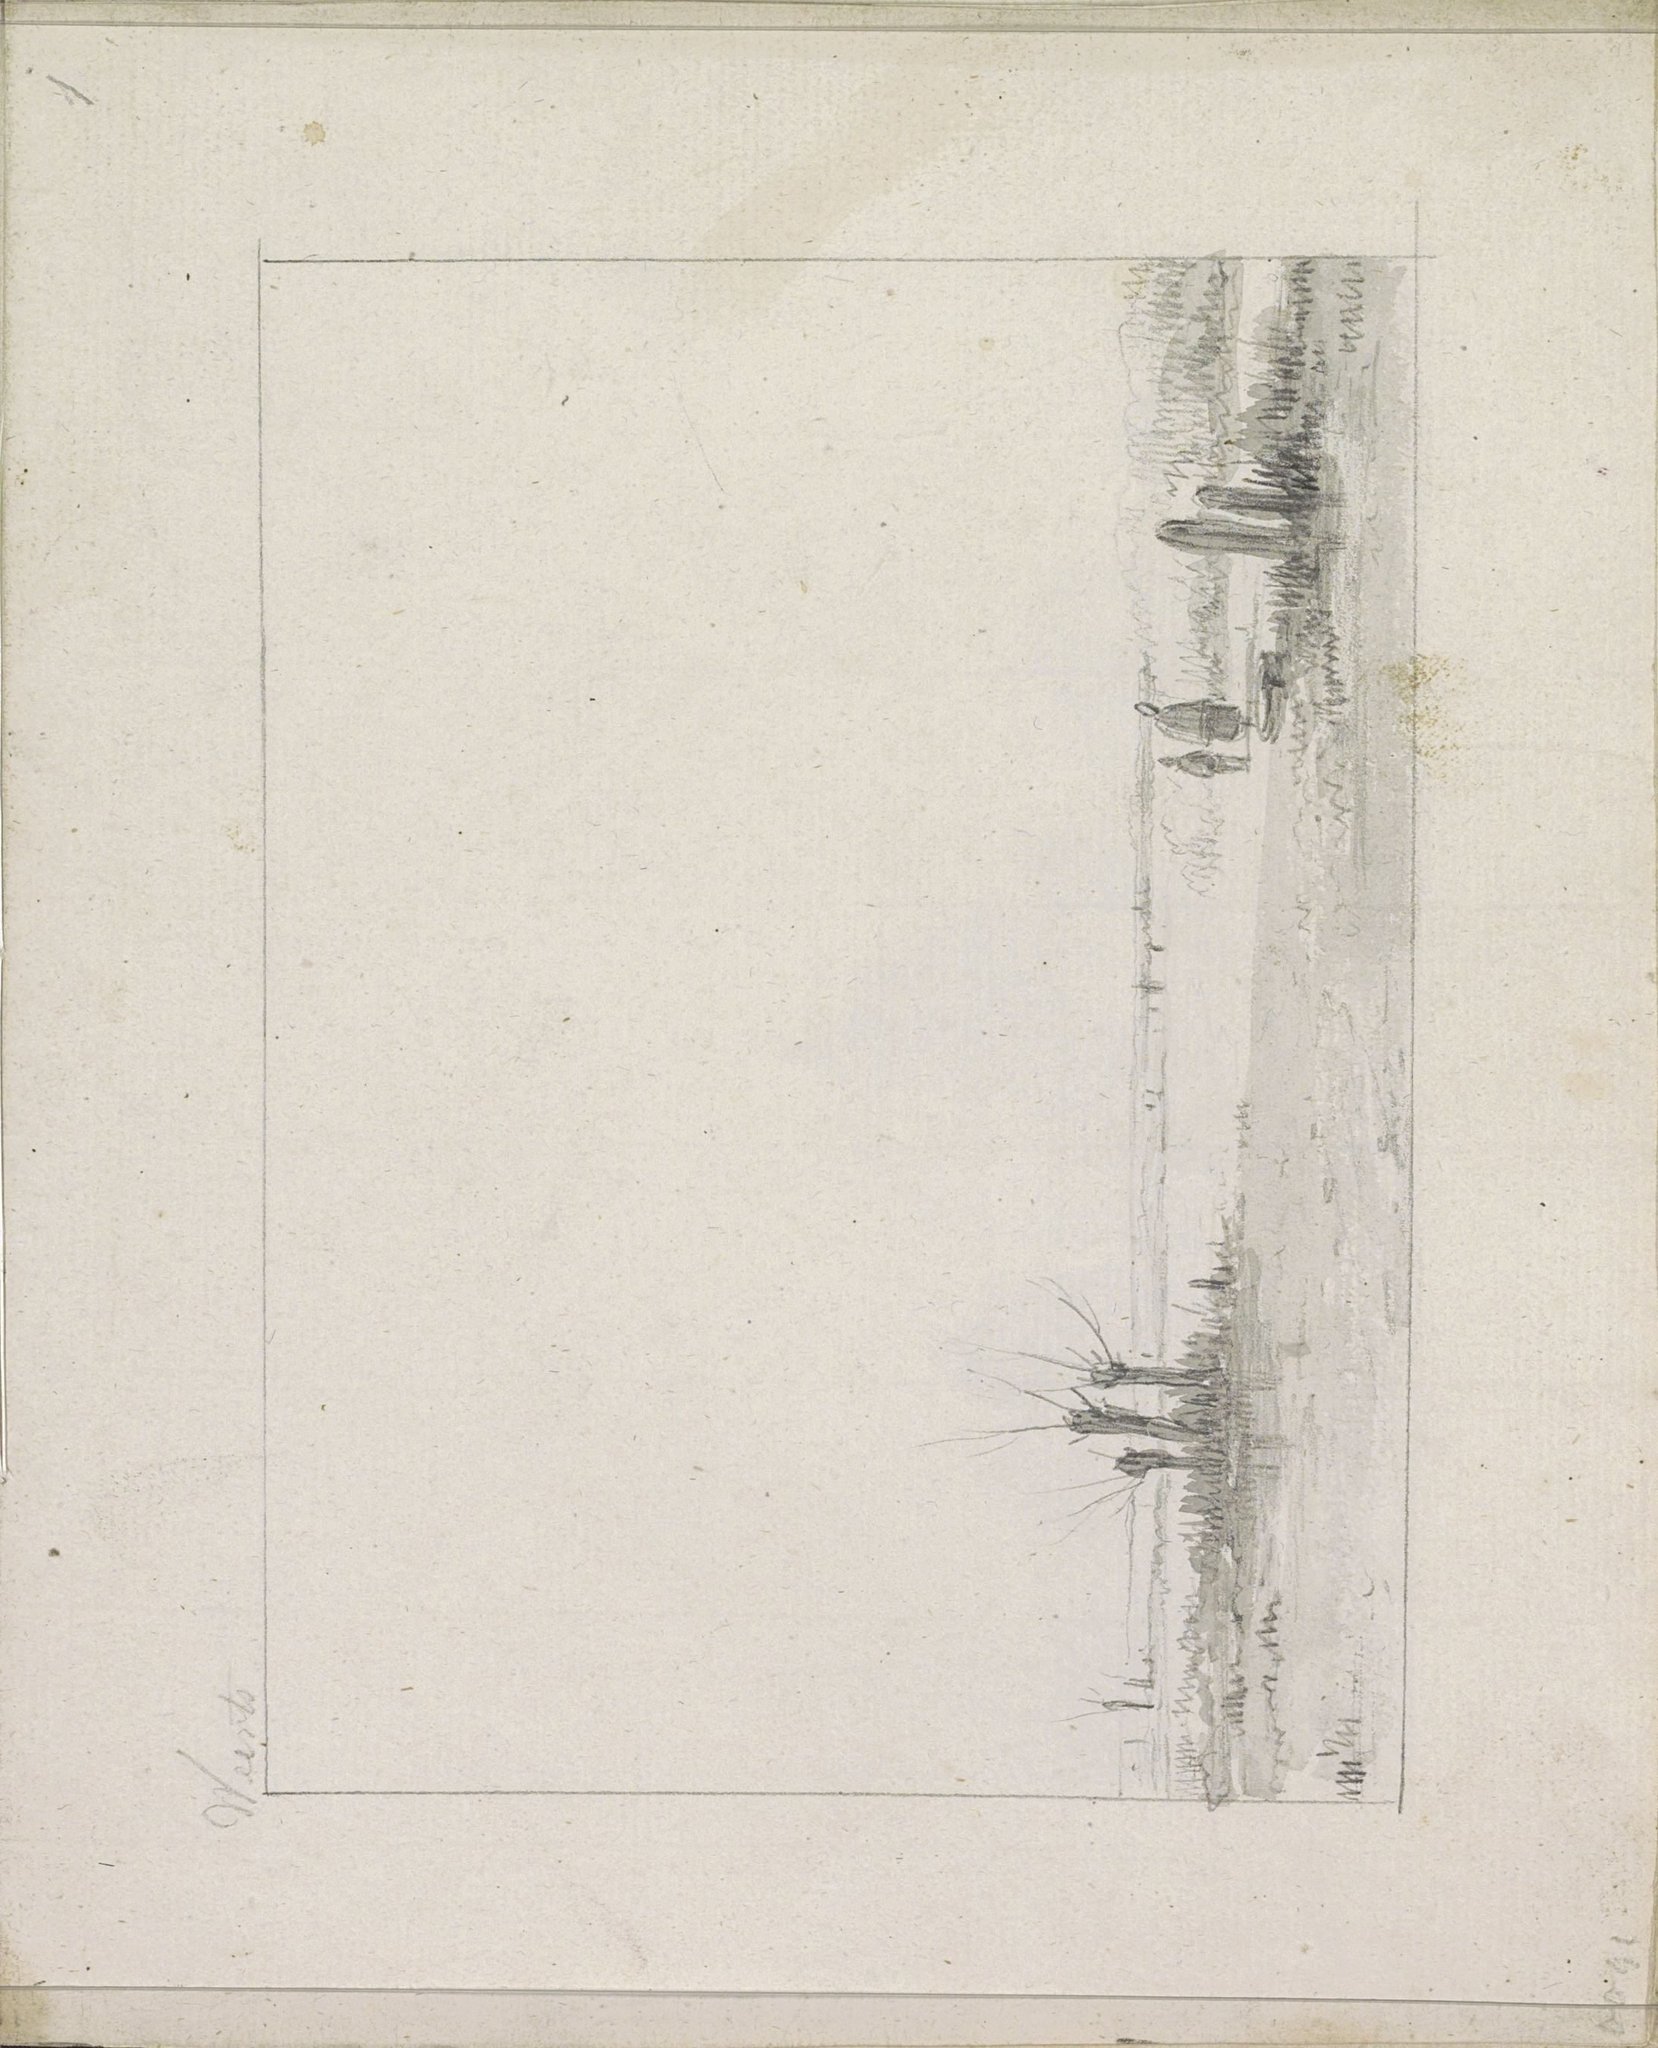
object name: sketchbook leaf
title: Landschap met figuren en knotwilgen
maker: andreas schelfhout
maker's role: draughtsman, painter, print maker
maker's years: 1787-1870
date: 1825-1829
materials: paper, pencil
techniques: brush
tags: trees: willow, landscapes (+ landscape with figures, staffage)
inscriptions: annotation: ‘Weerts’, number: ‘1/ 0091’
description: Blad 5 recto uit een schetsboek met 95 bladen.